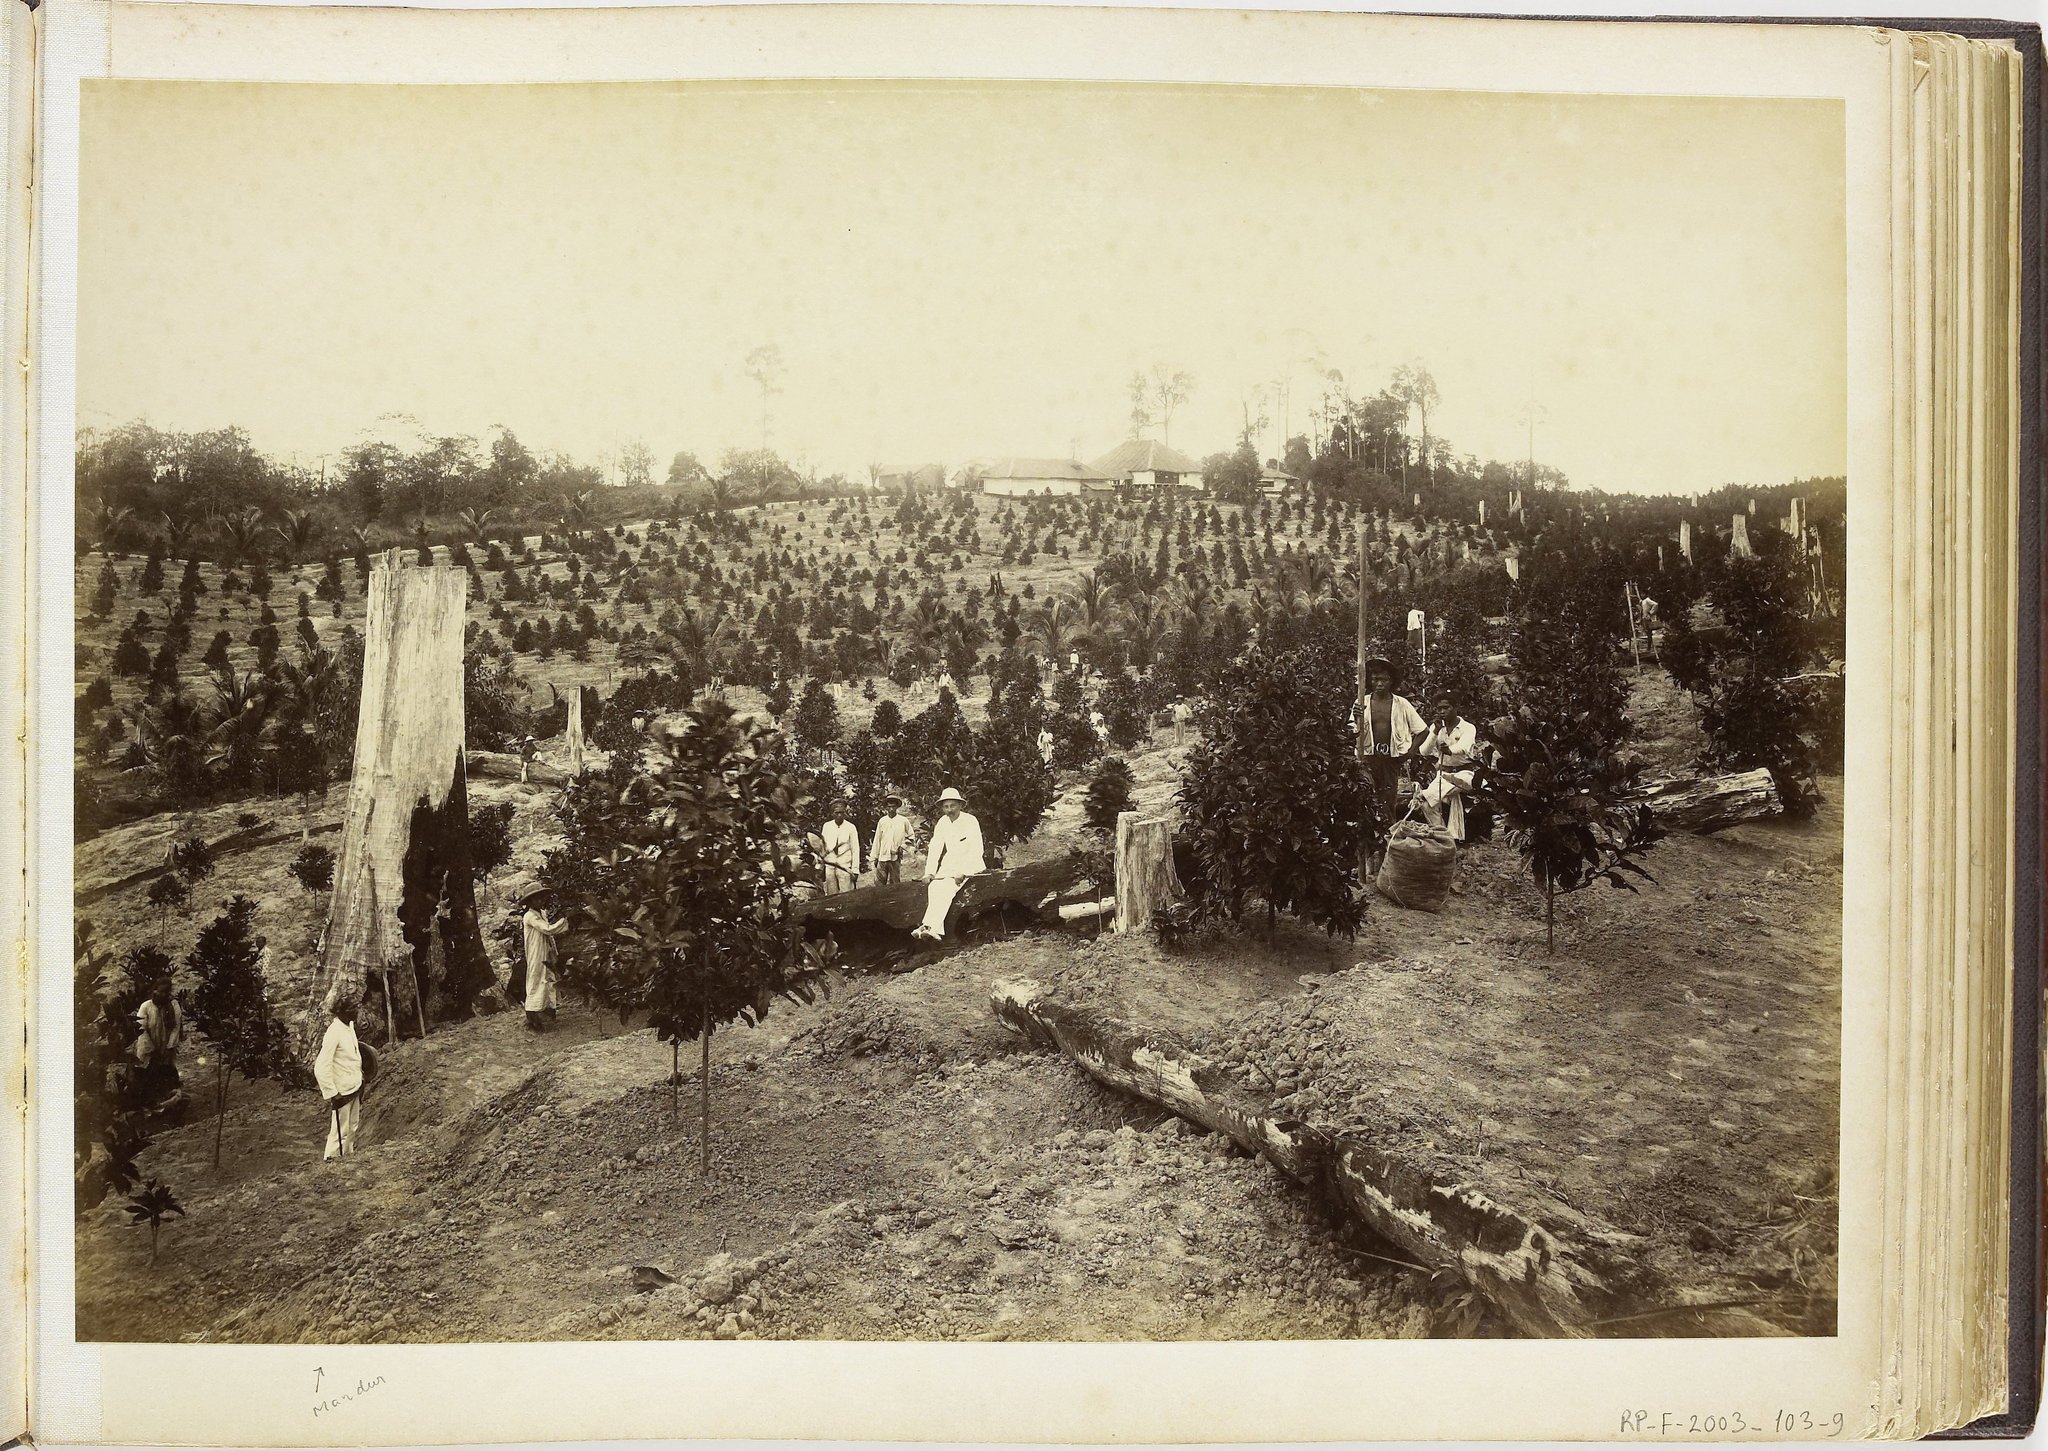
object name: photograph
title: Op de koffieplantage, Langkat Sumatra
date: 1900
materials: cardboard, paper, photographic support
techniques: albumen print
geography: bindjai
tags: sumatra